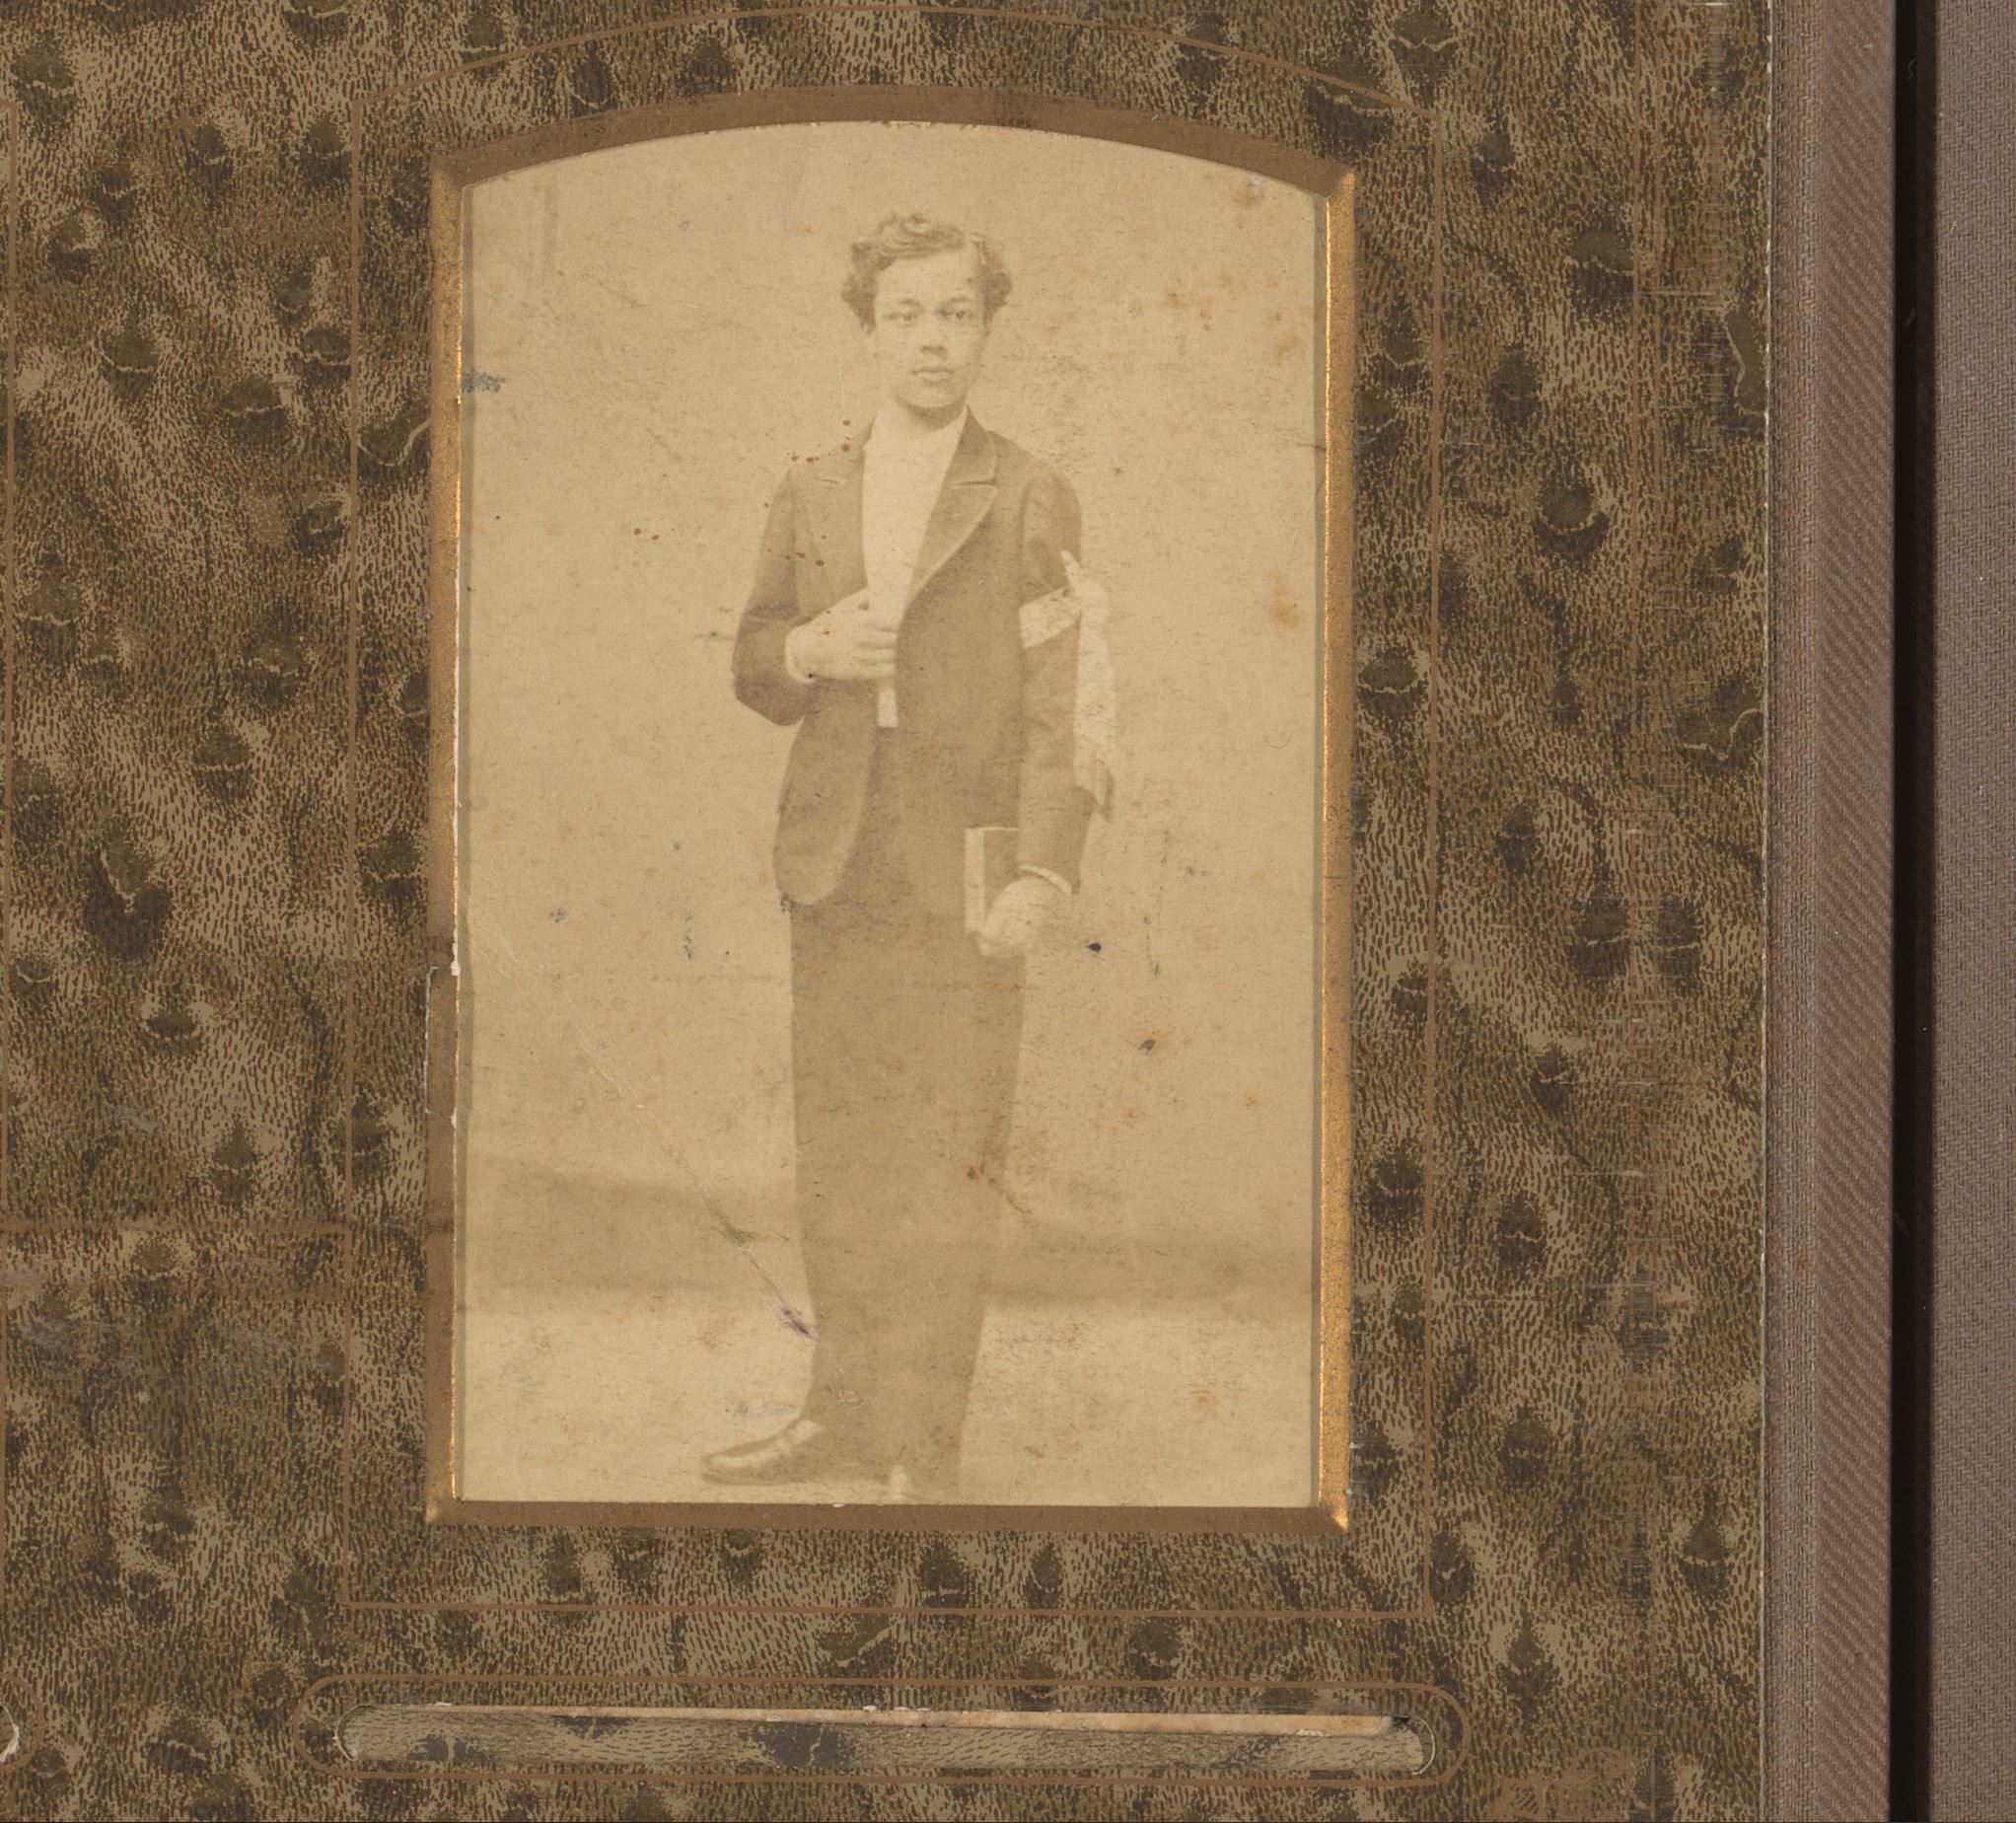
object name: carte de visite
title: Portret van een jongen met communie-strik om de arm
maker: jouve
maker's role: fotograaf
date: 1880-1900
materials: cardboard, photographic support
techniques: albumen print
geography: grenoble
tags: first communion, historical persons, youth, adolescent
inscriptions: inscription: ‘Jouve, Peintre Photographe/ 52, Quai Perrière, 52./ Grenoble’